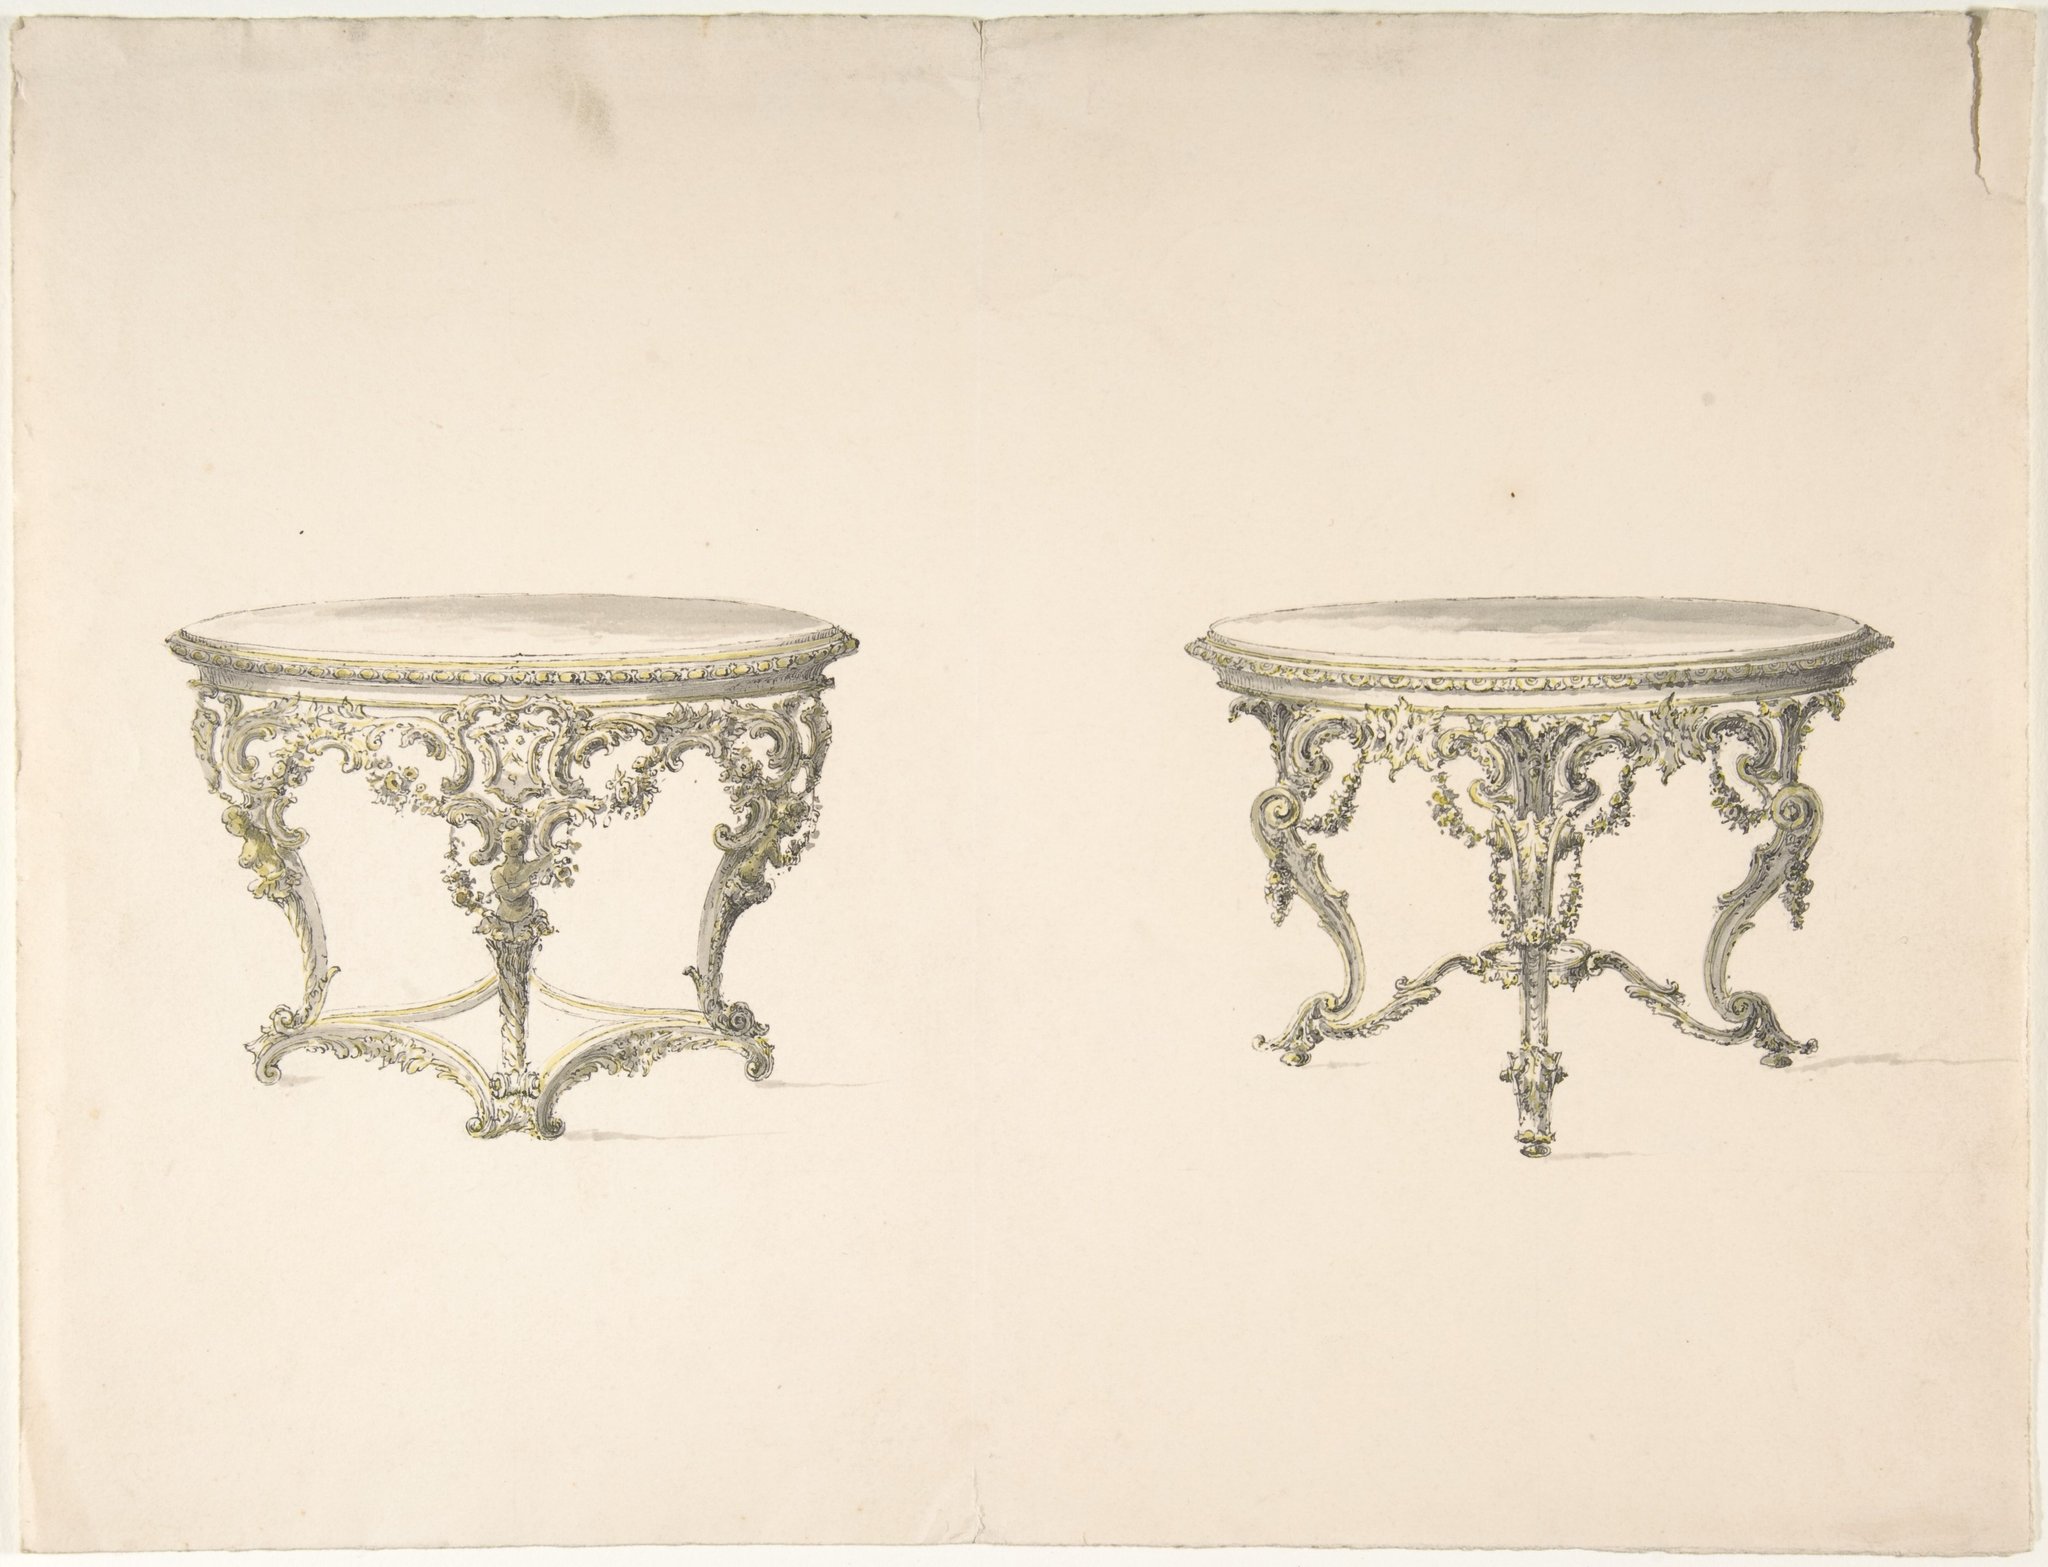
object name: drawing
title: Design for Two Round Tables with Foliate Rococo Style Carving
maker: anonymous, british, 19th century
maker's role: artist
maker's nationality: british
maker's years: 1800-1900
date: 1801-1833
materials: ink, watercolor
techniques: brush, pen, wash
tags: tables